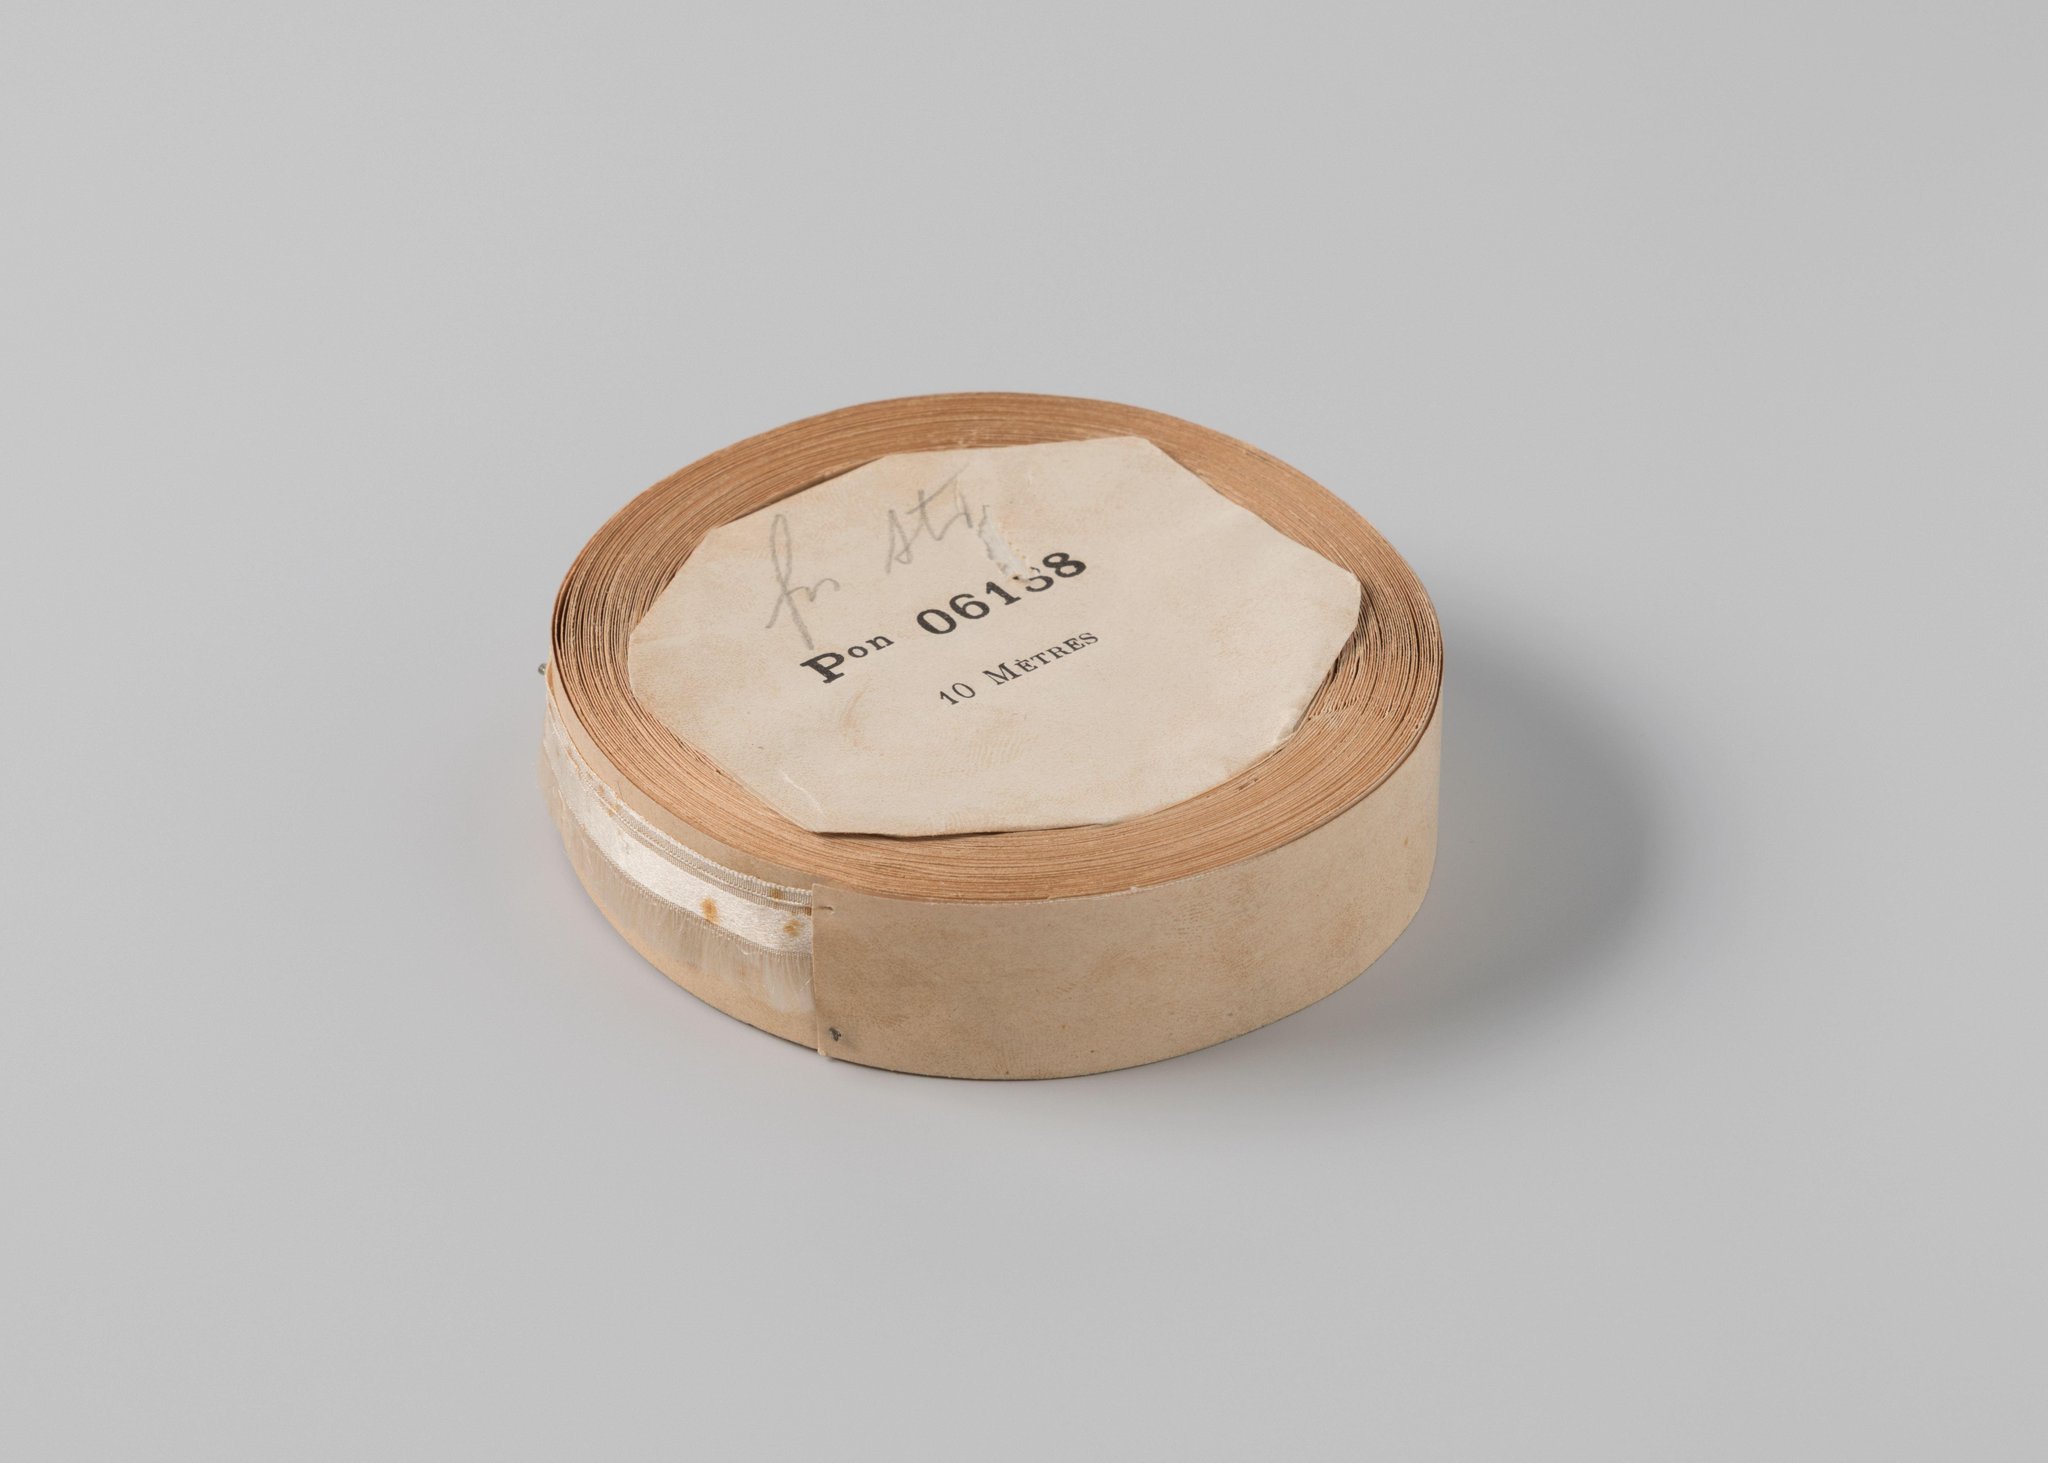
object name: rol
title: Rol met wit satijnlint met één gerafelde zijde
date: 1935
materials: cardboard, paper, textile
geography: nijmegen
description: Rol met wit satijnlint met één gerafelde zijde.